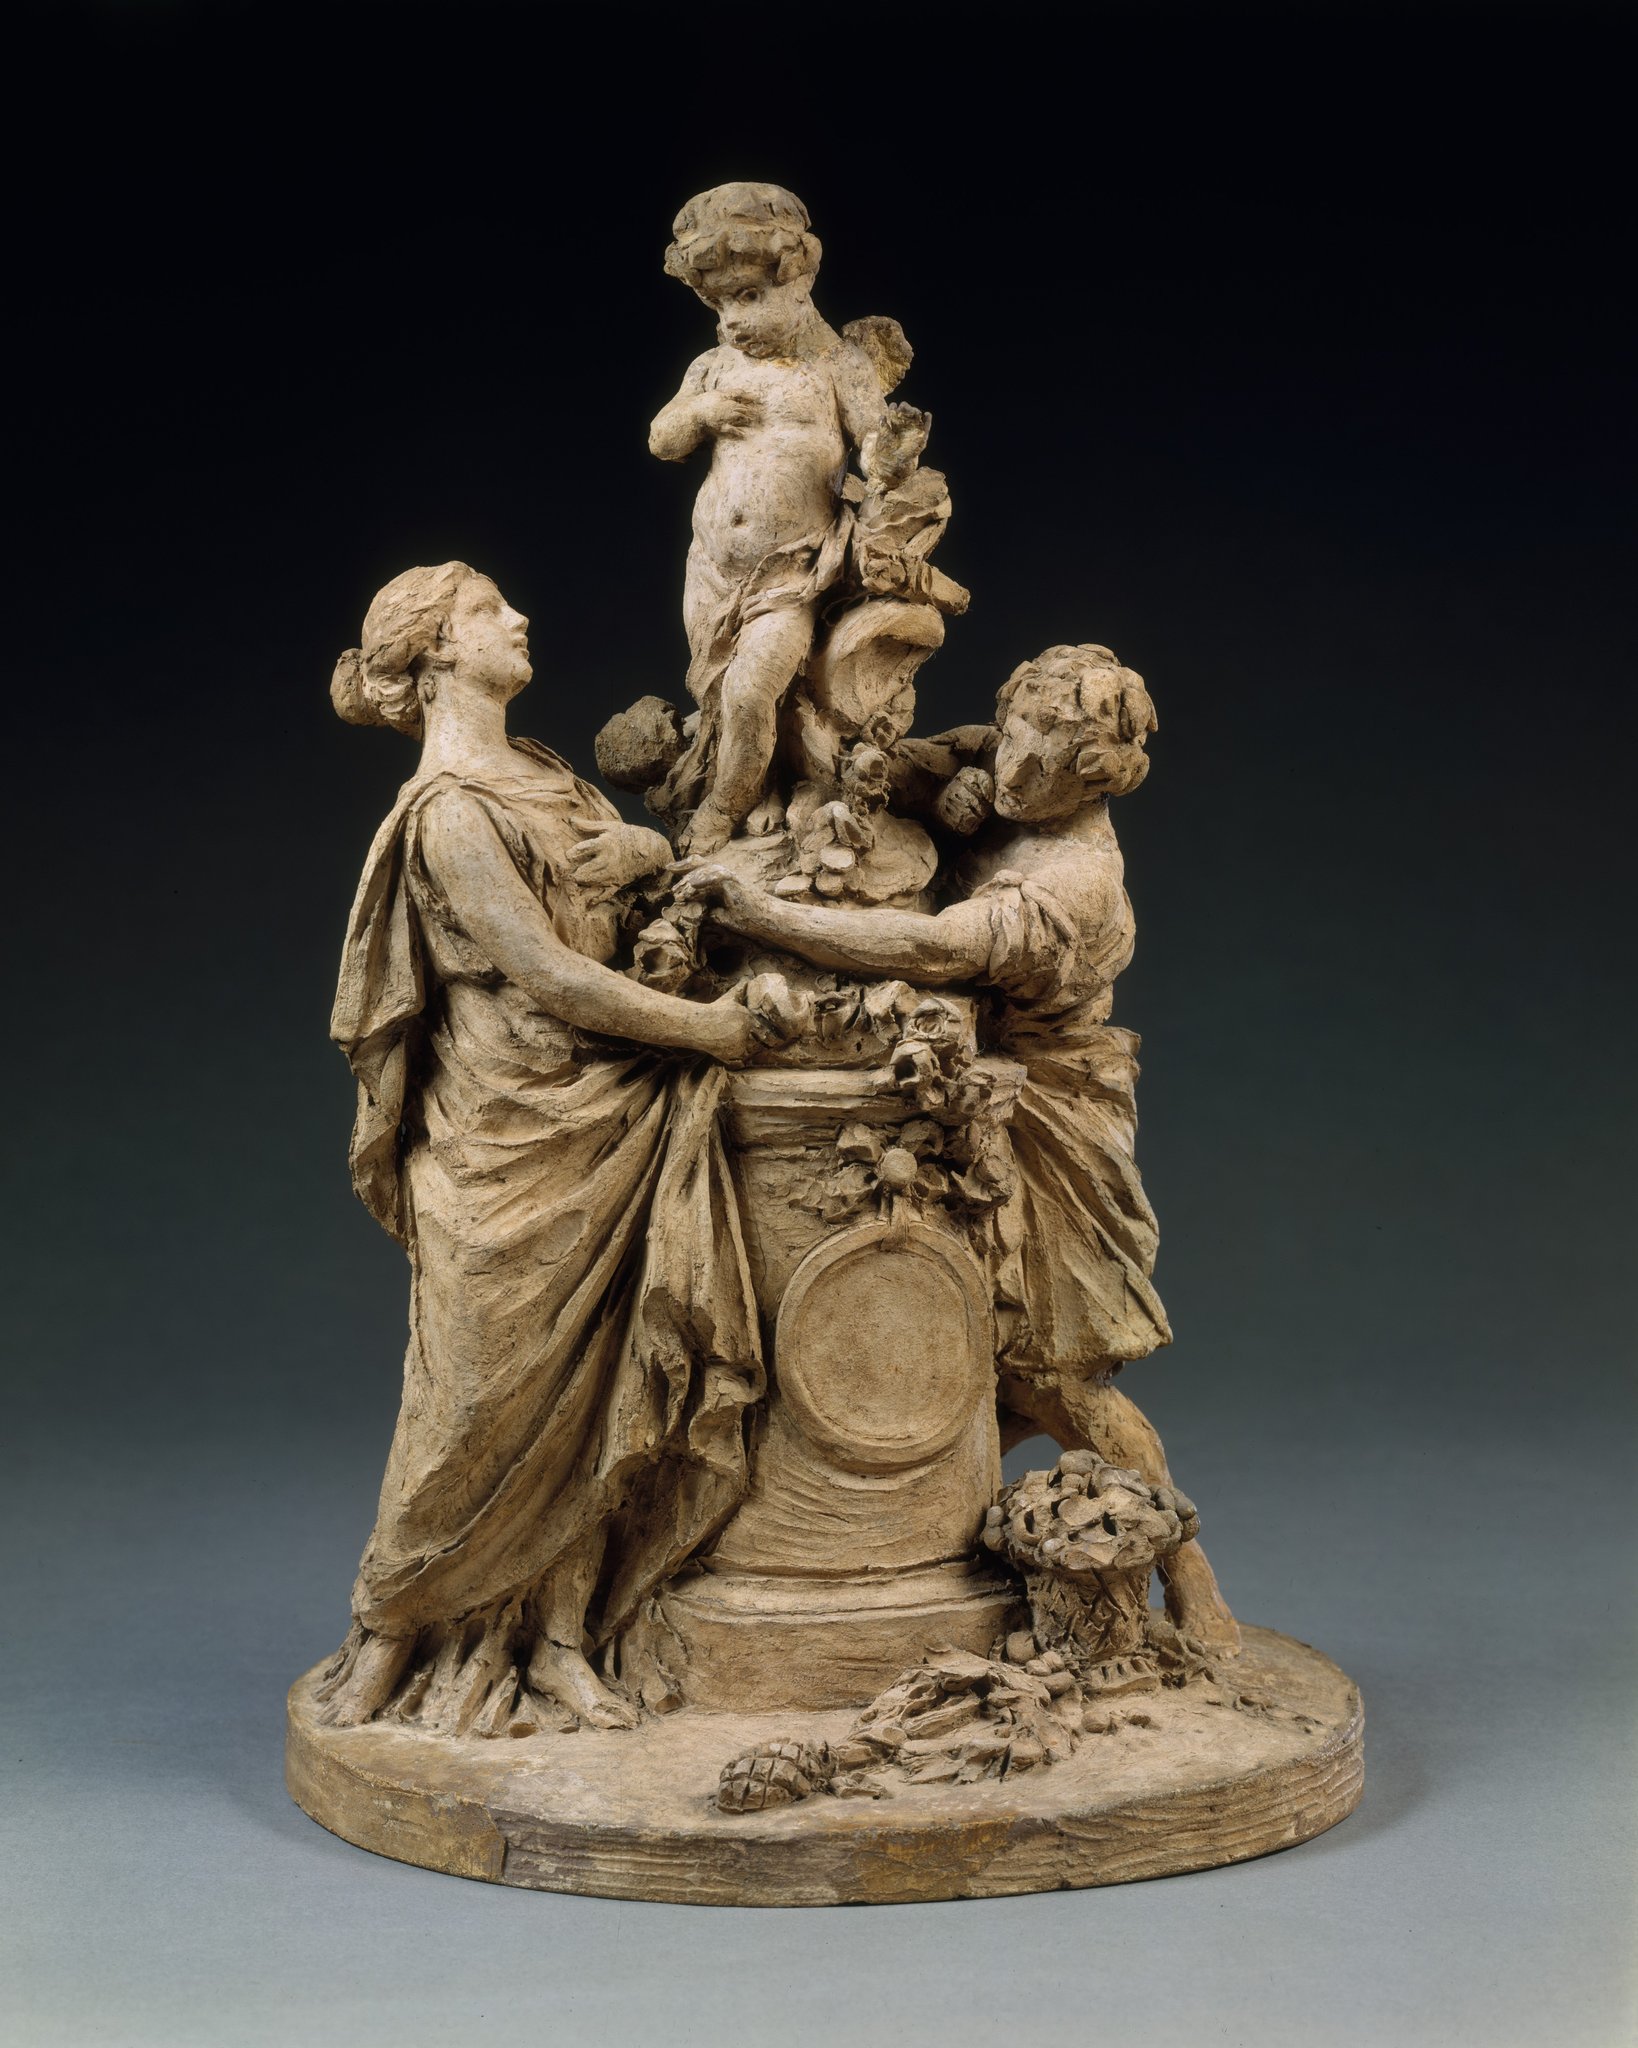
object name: statuette group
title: The Theft of the Rose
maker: louis simon boizot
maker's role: modeler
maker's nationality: french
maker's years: 1743-1809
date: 1789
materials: pigment, terracotta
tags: men,women,cupid